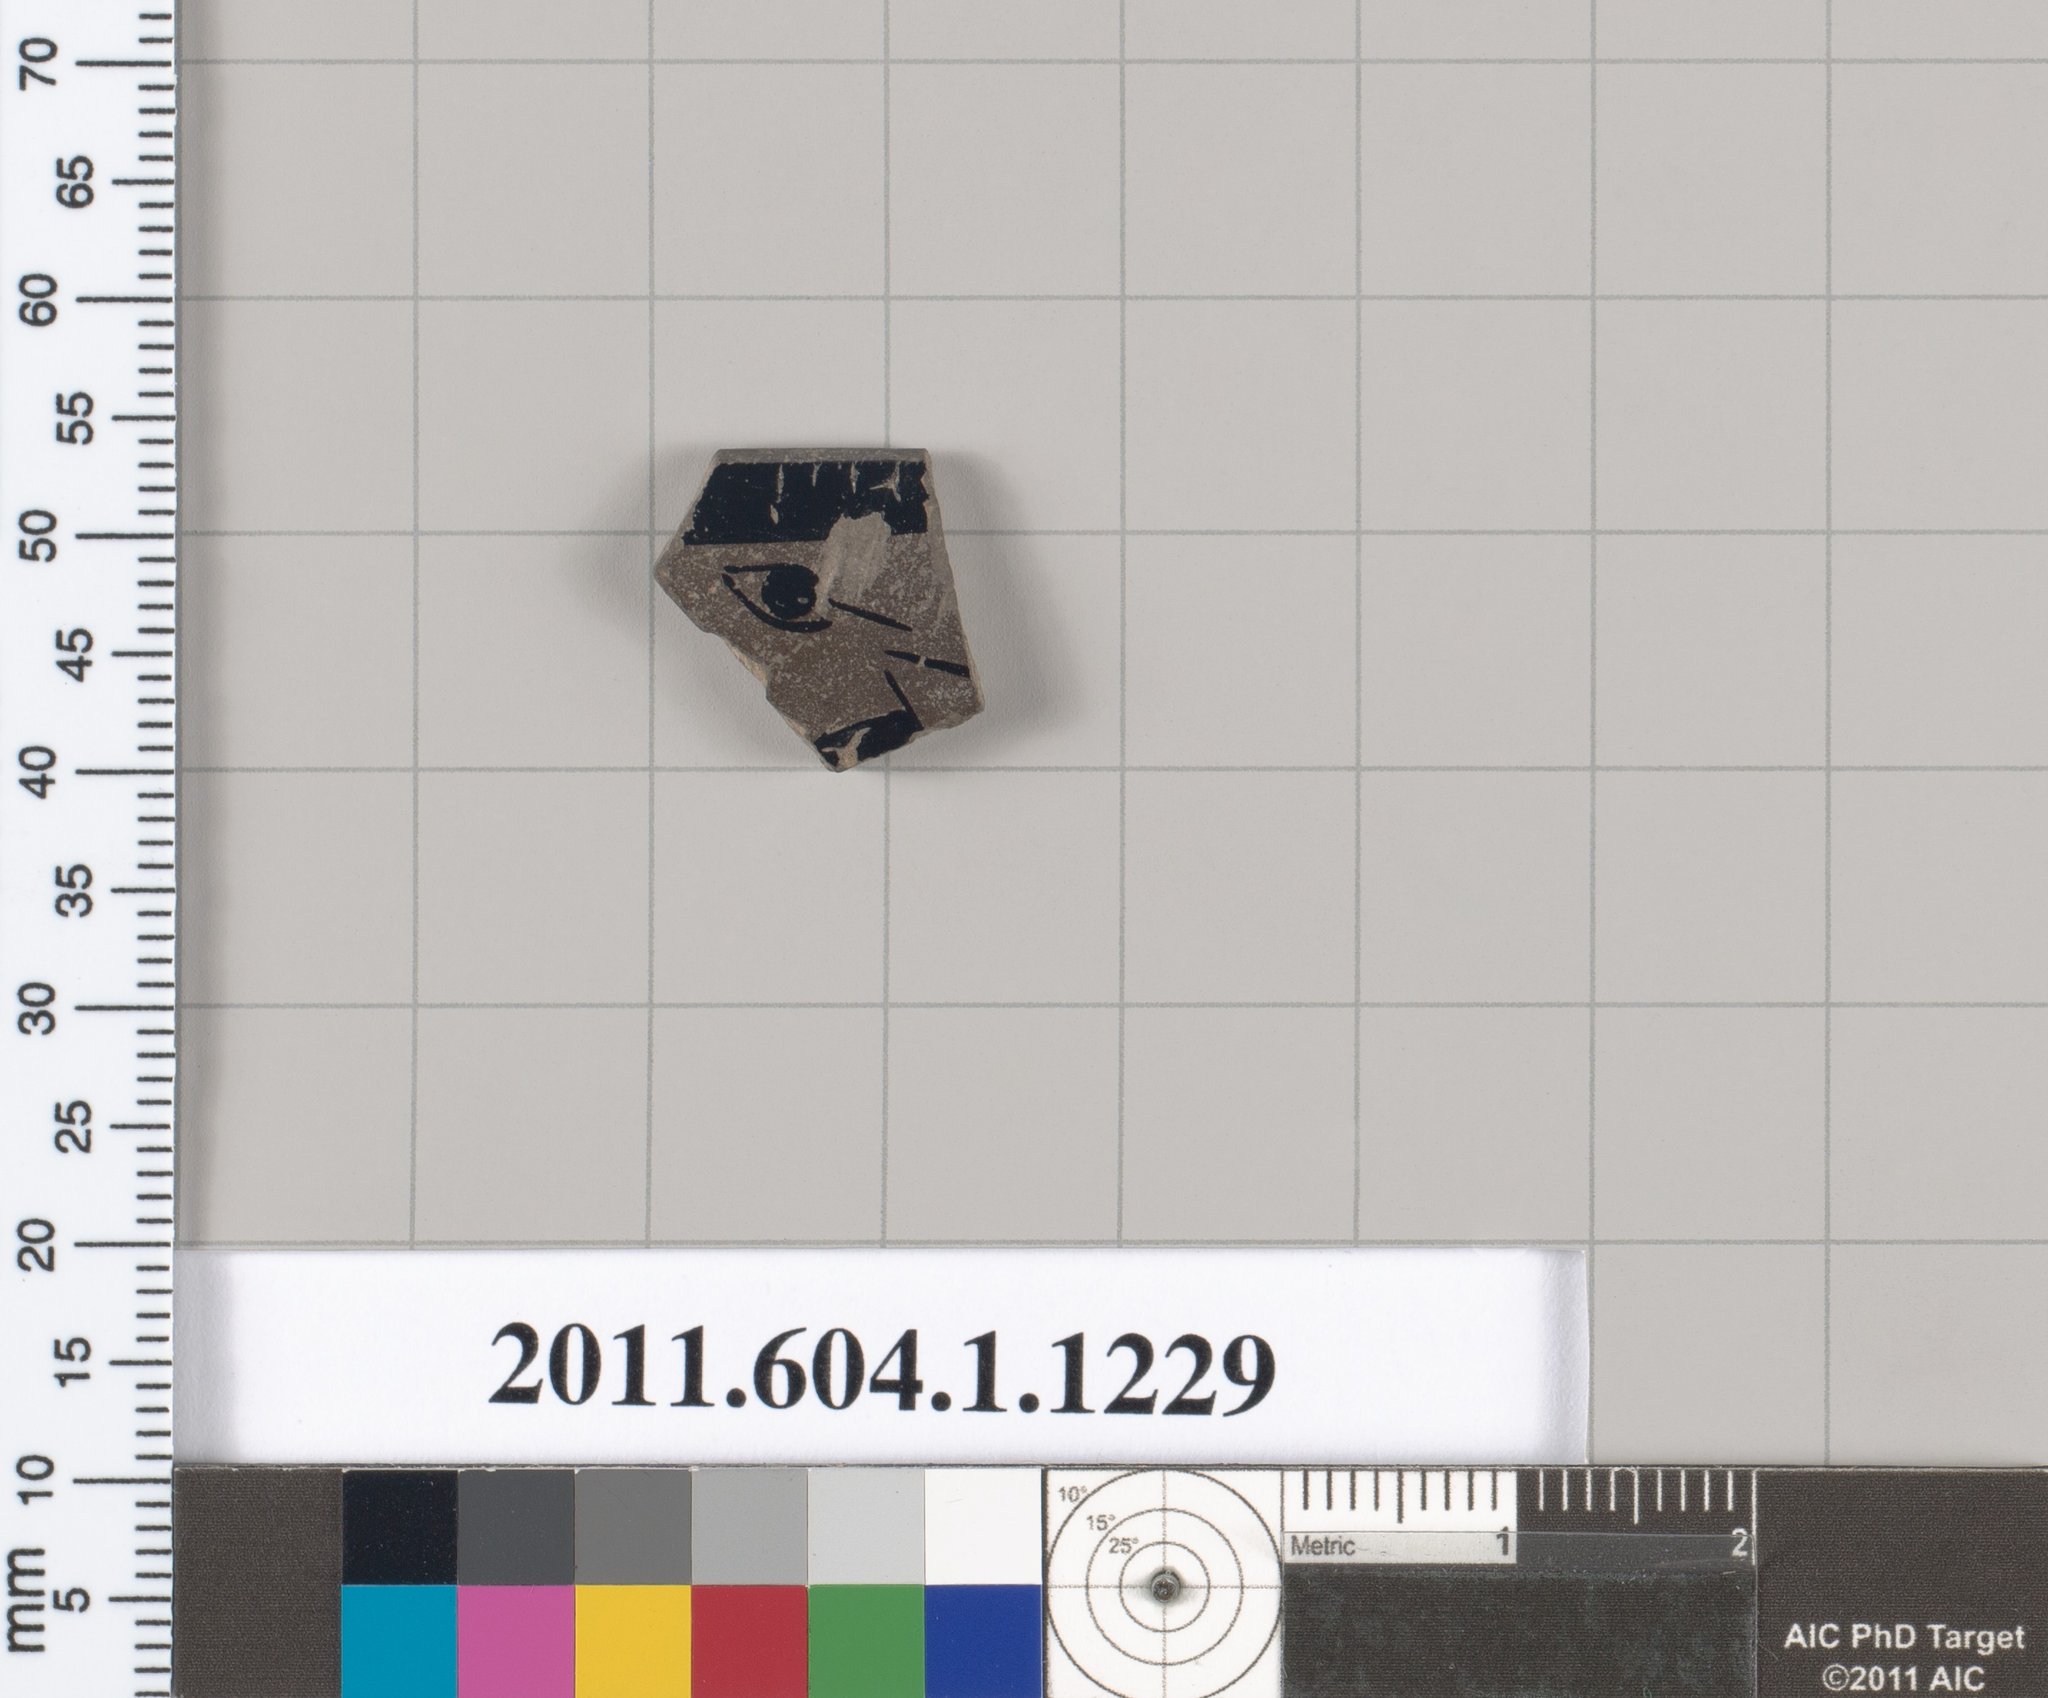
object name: kylix fragment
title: Terracotta rim fragment of a kylix (drinking cup)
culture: greek, attic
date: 500-480 BCE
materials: terracotta